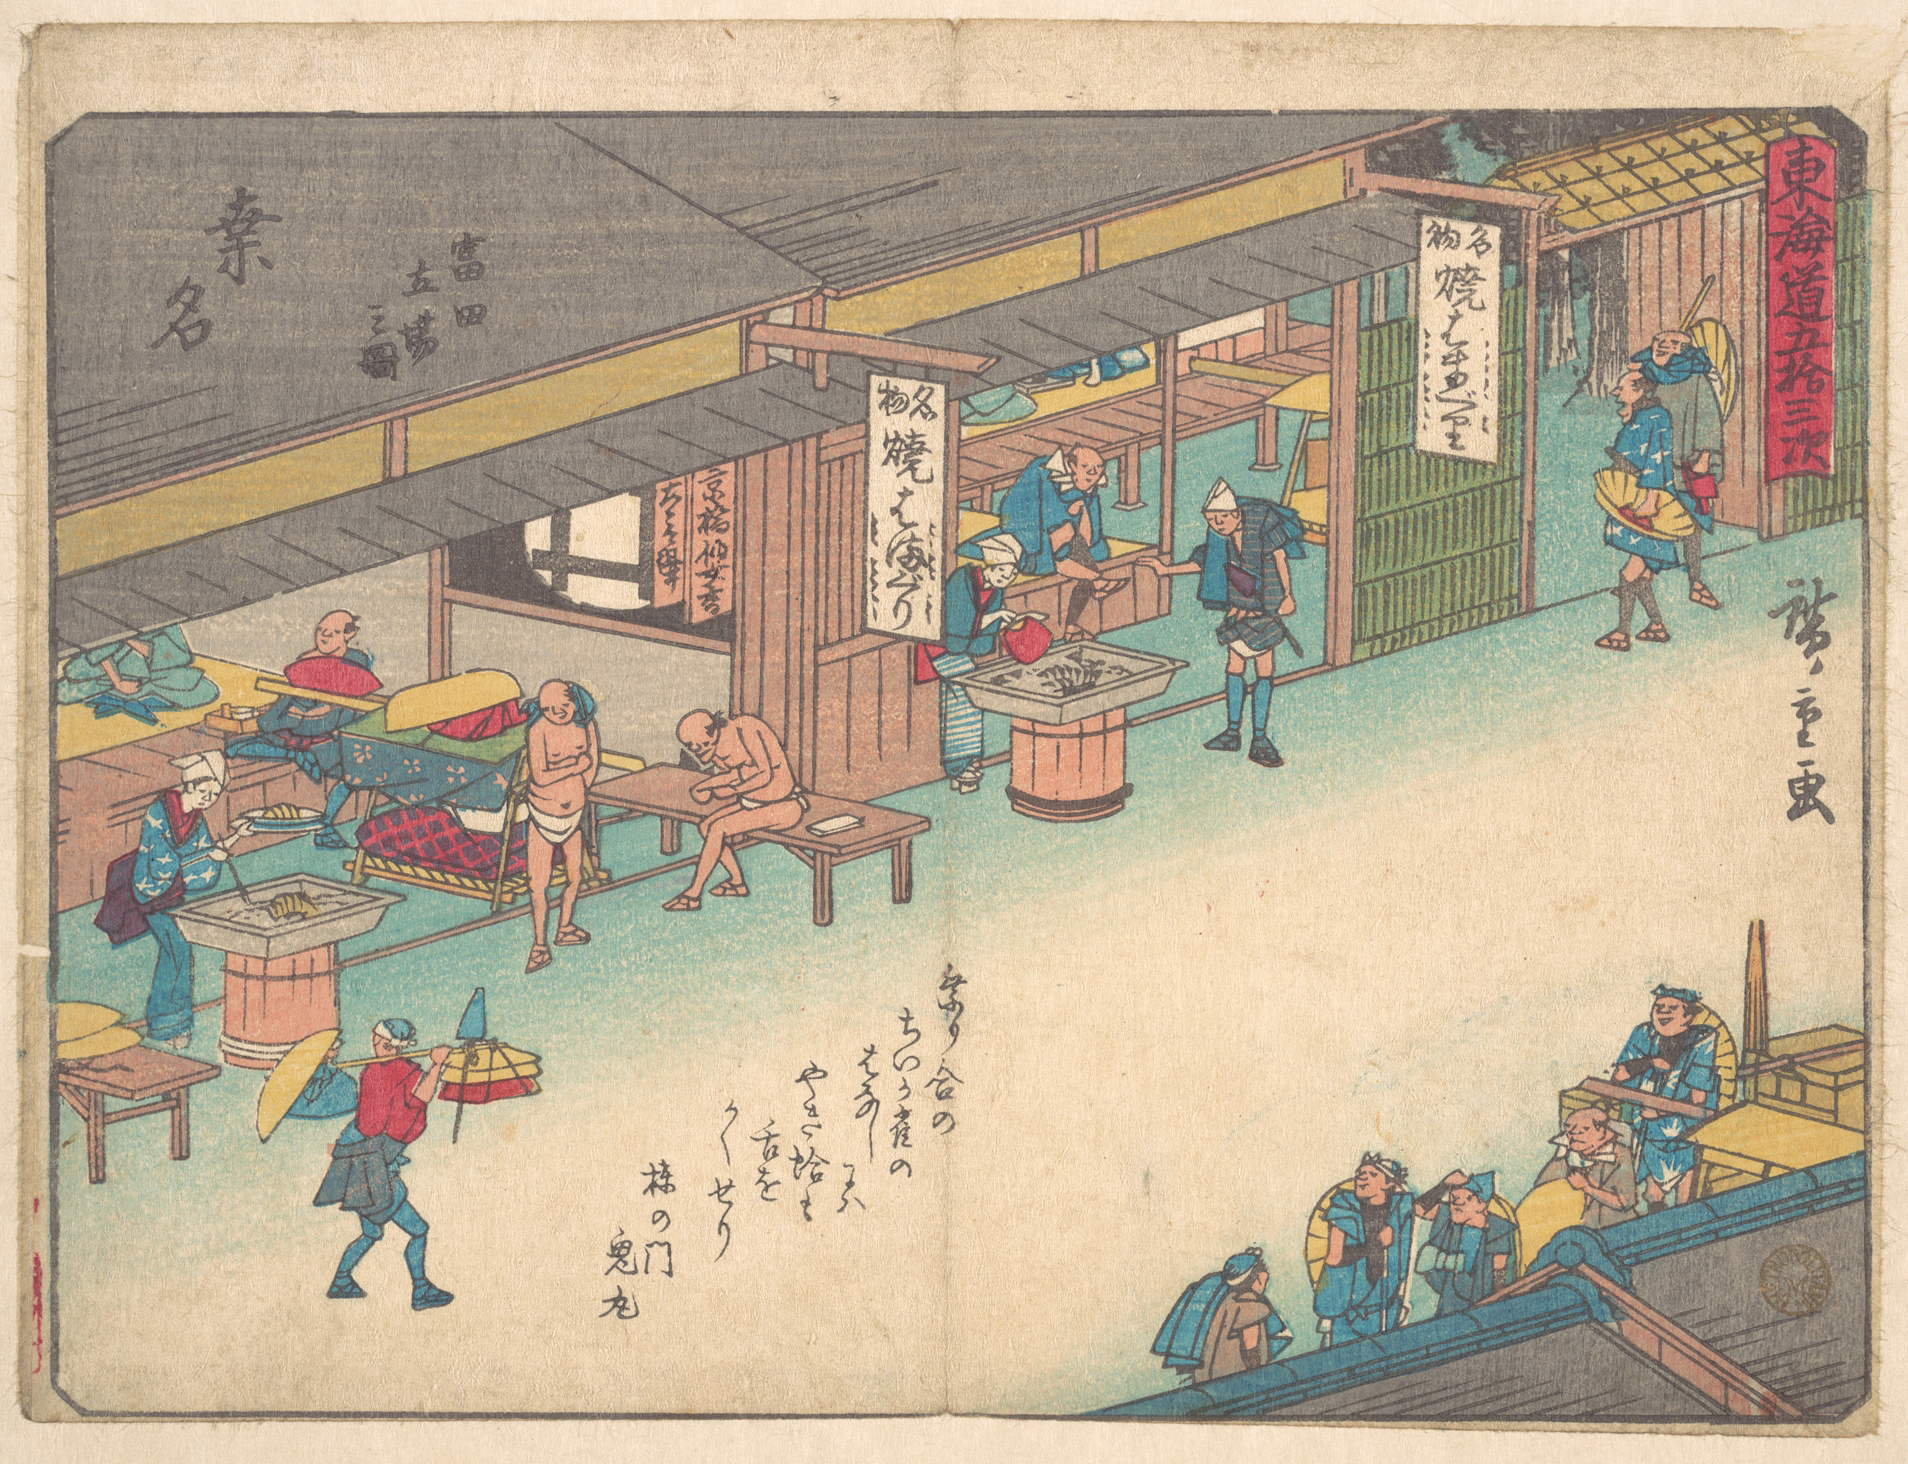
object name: print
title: Kuwana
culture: japanese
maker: utagawa hiroshige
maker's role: artist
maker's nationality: japanese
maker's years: 1797-1858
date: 1838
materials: ink, paper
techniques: woodblock print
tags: human figures,street scene,working